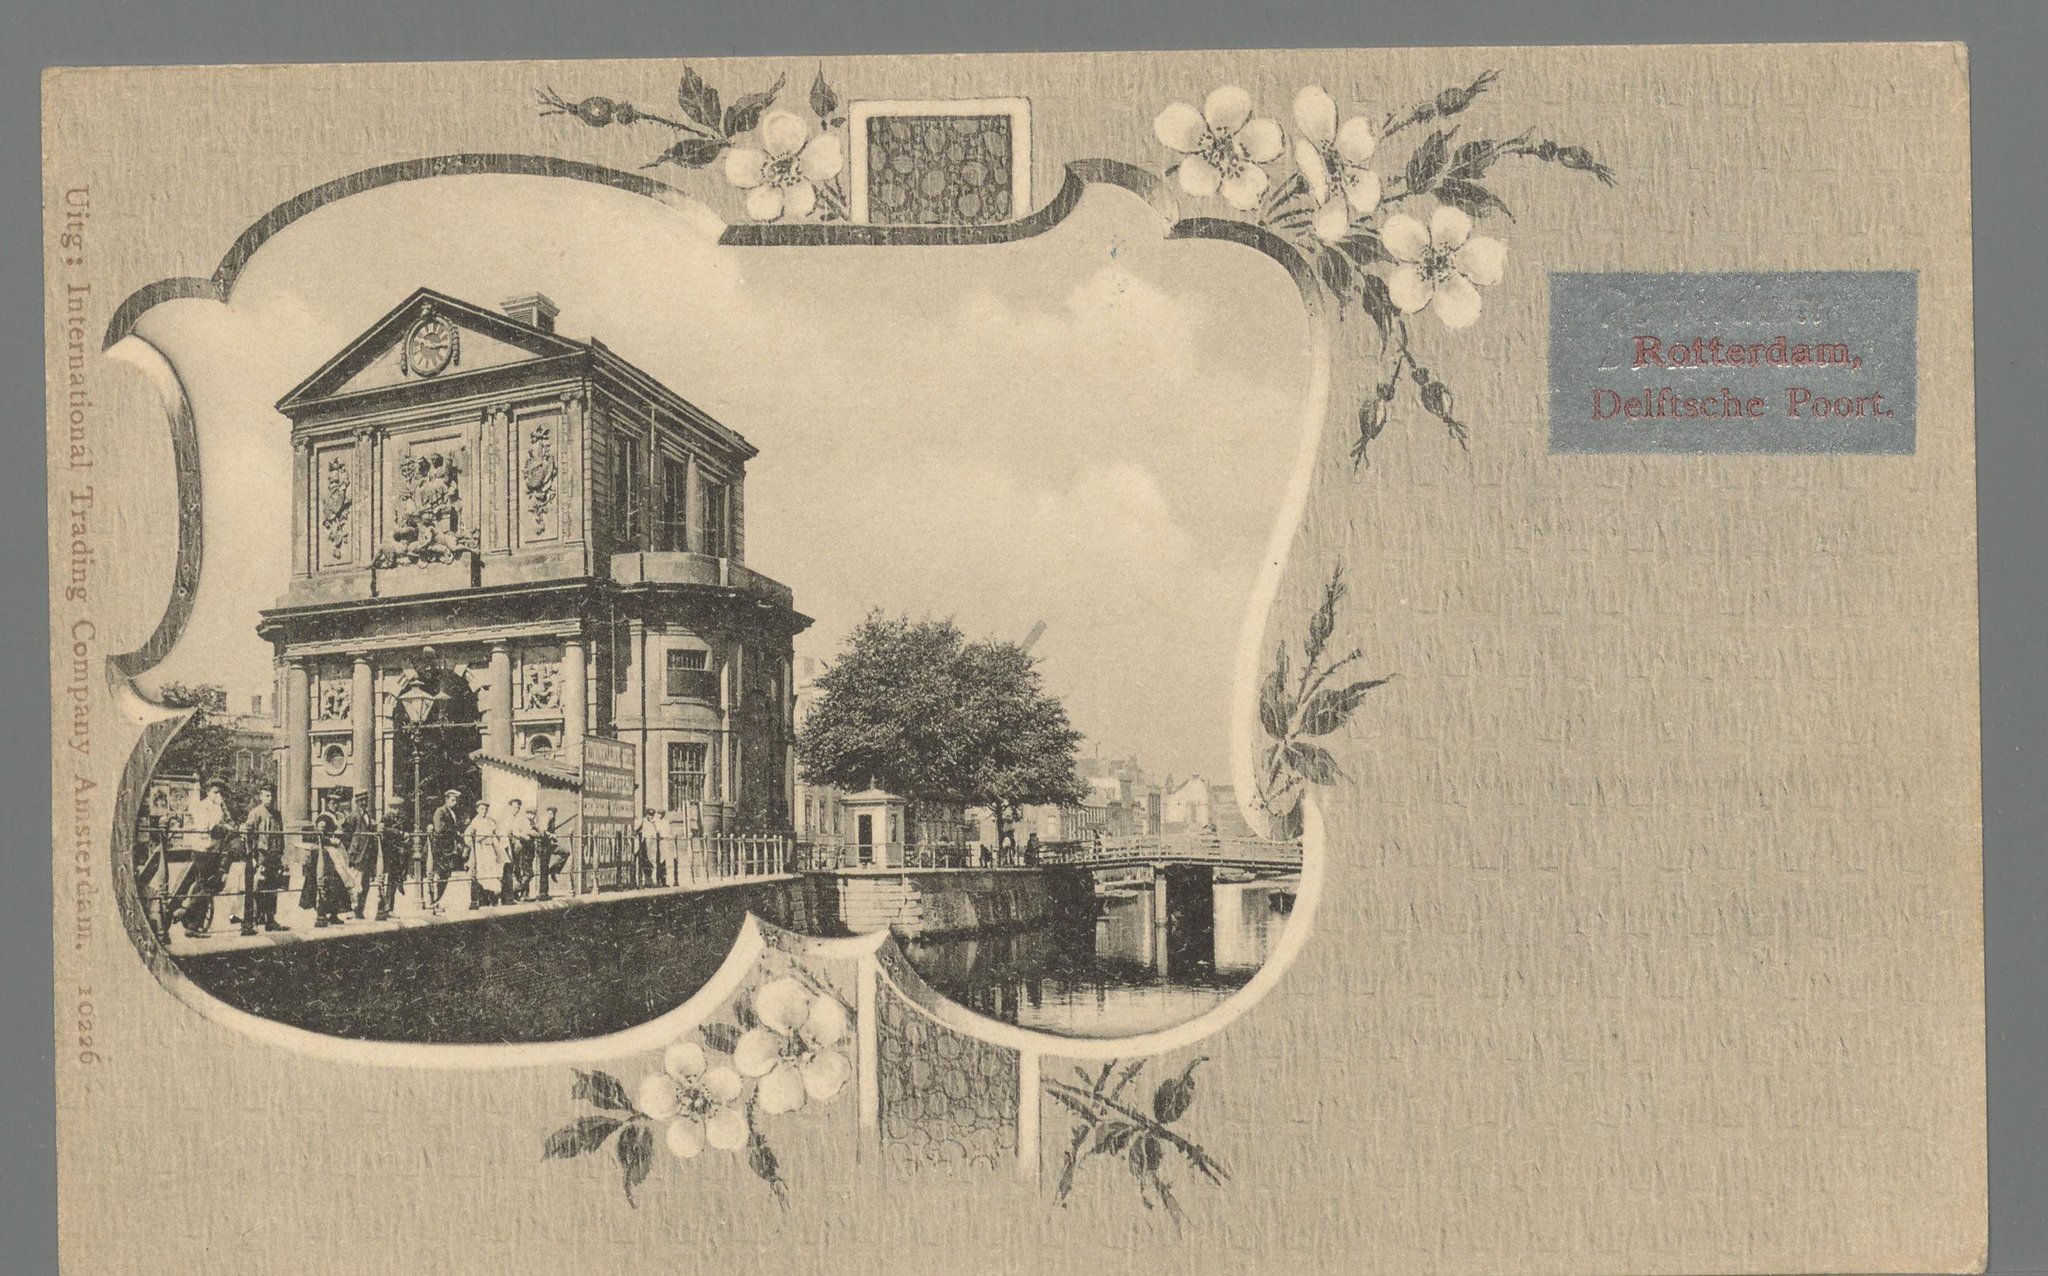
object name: ansichtkaart, prentbriefkaart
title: Rotterdam, Delftsche Poort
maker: Anonymous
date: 1892-1905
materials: cardboard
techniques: photograph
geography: rotterdam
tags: city-gate